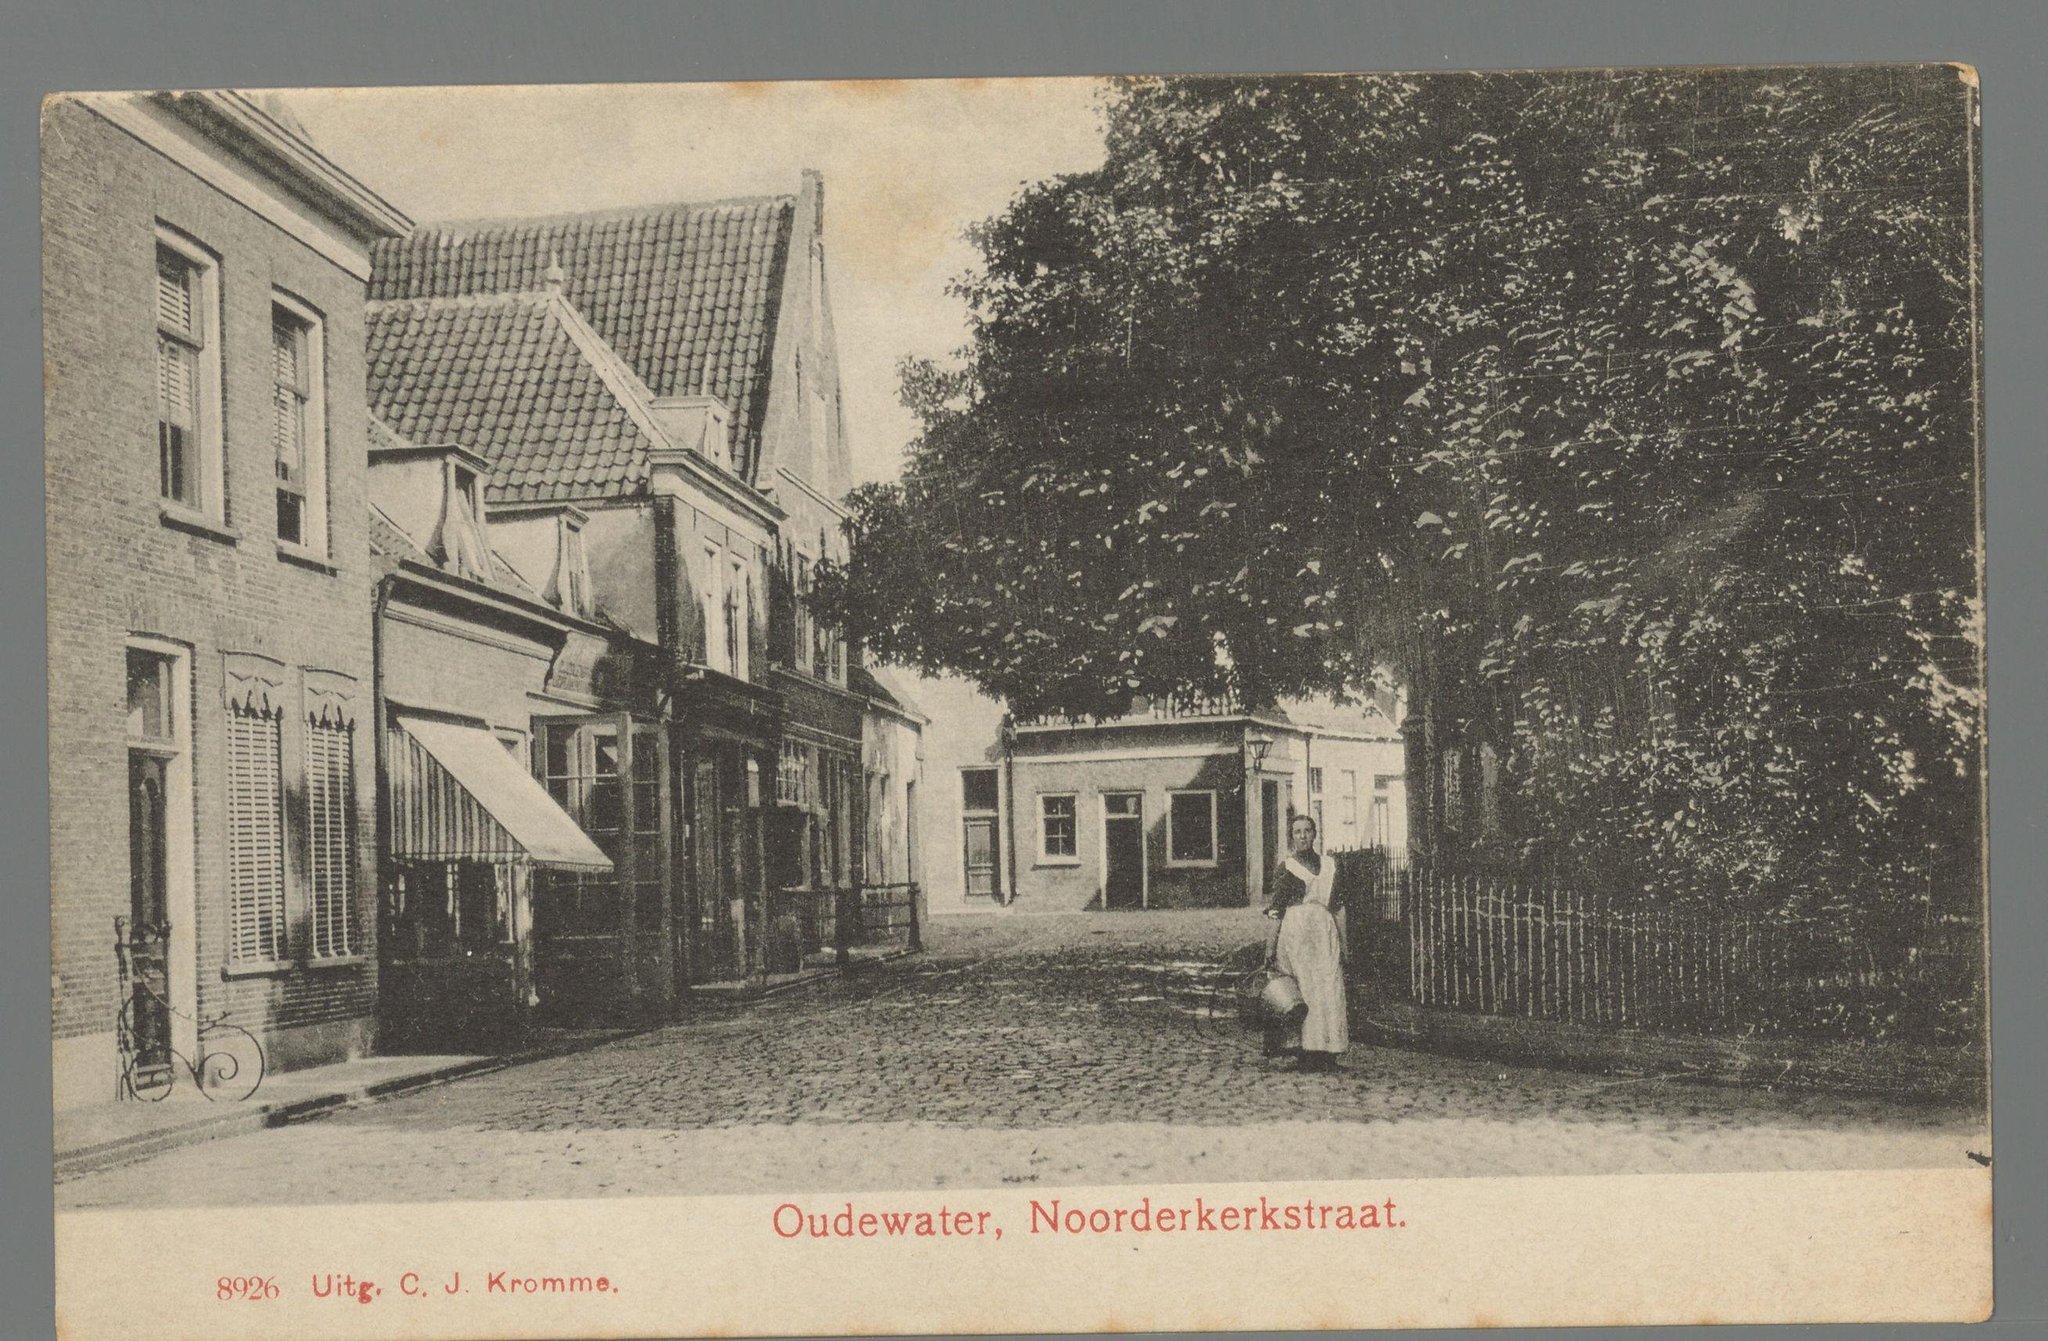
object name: ansichtkaart, prentbriefkaart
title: Oudewater, Noorderkerkstraat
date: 1905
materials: cardboard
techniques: photograph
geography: oudewater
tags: street